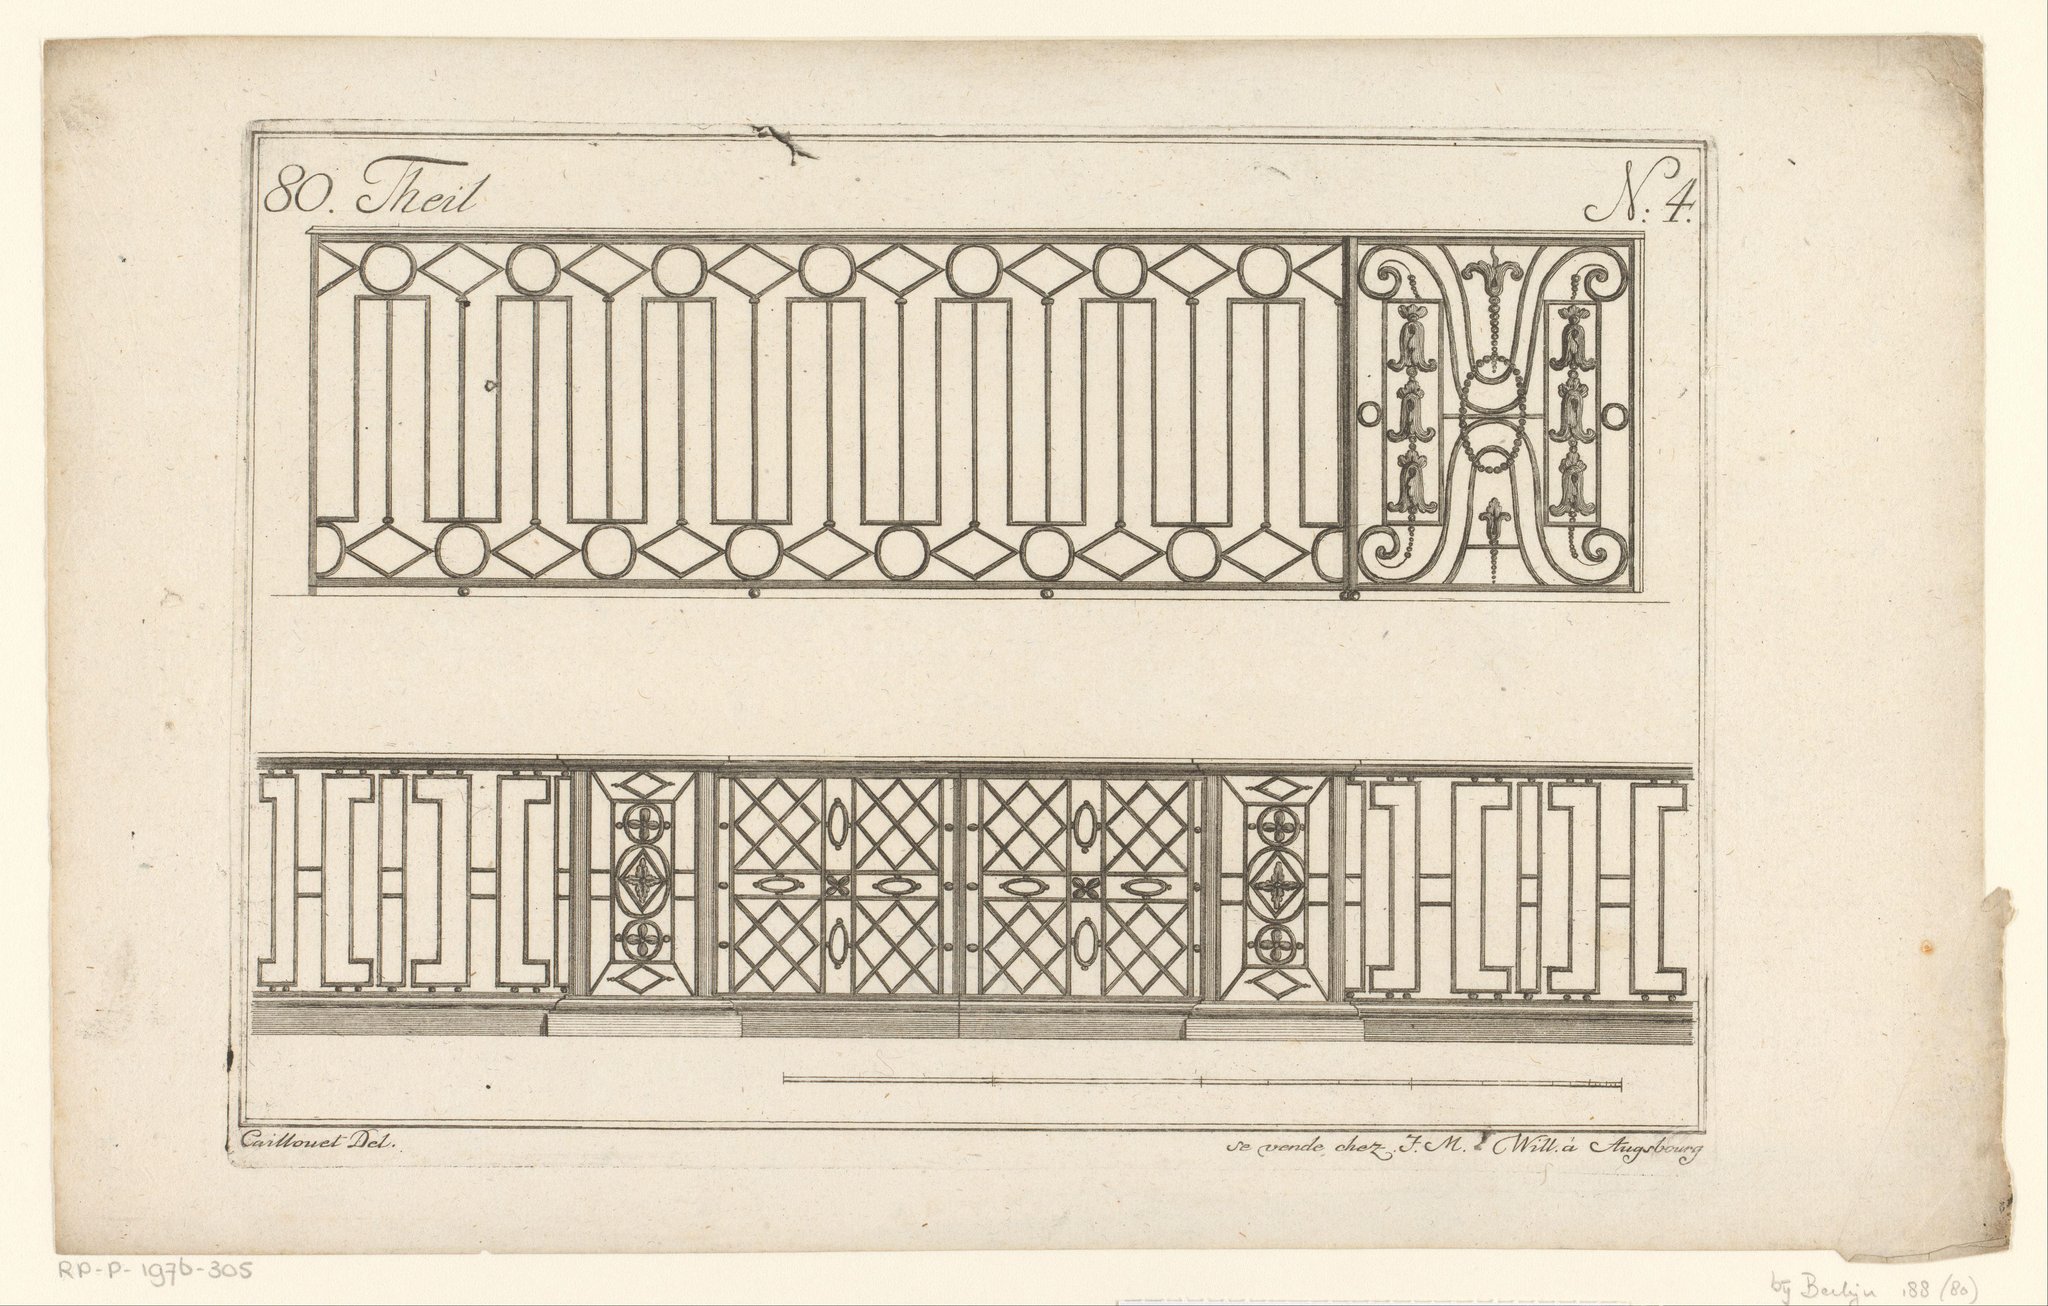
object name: ornament print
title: Twee hekwerken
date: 1737-1806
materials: paper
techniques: engraving, etching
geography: augsburg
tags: welding (industrial process), fence, wall, paling, flowers ~ ornament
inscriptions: collector's mark: Lugt 2228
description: Twee smeedijzeren hekwerken met bloemmotieven.